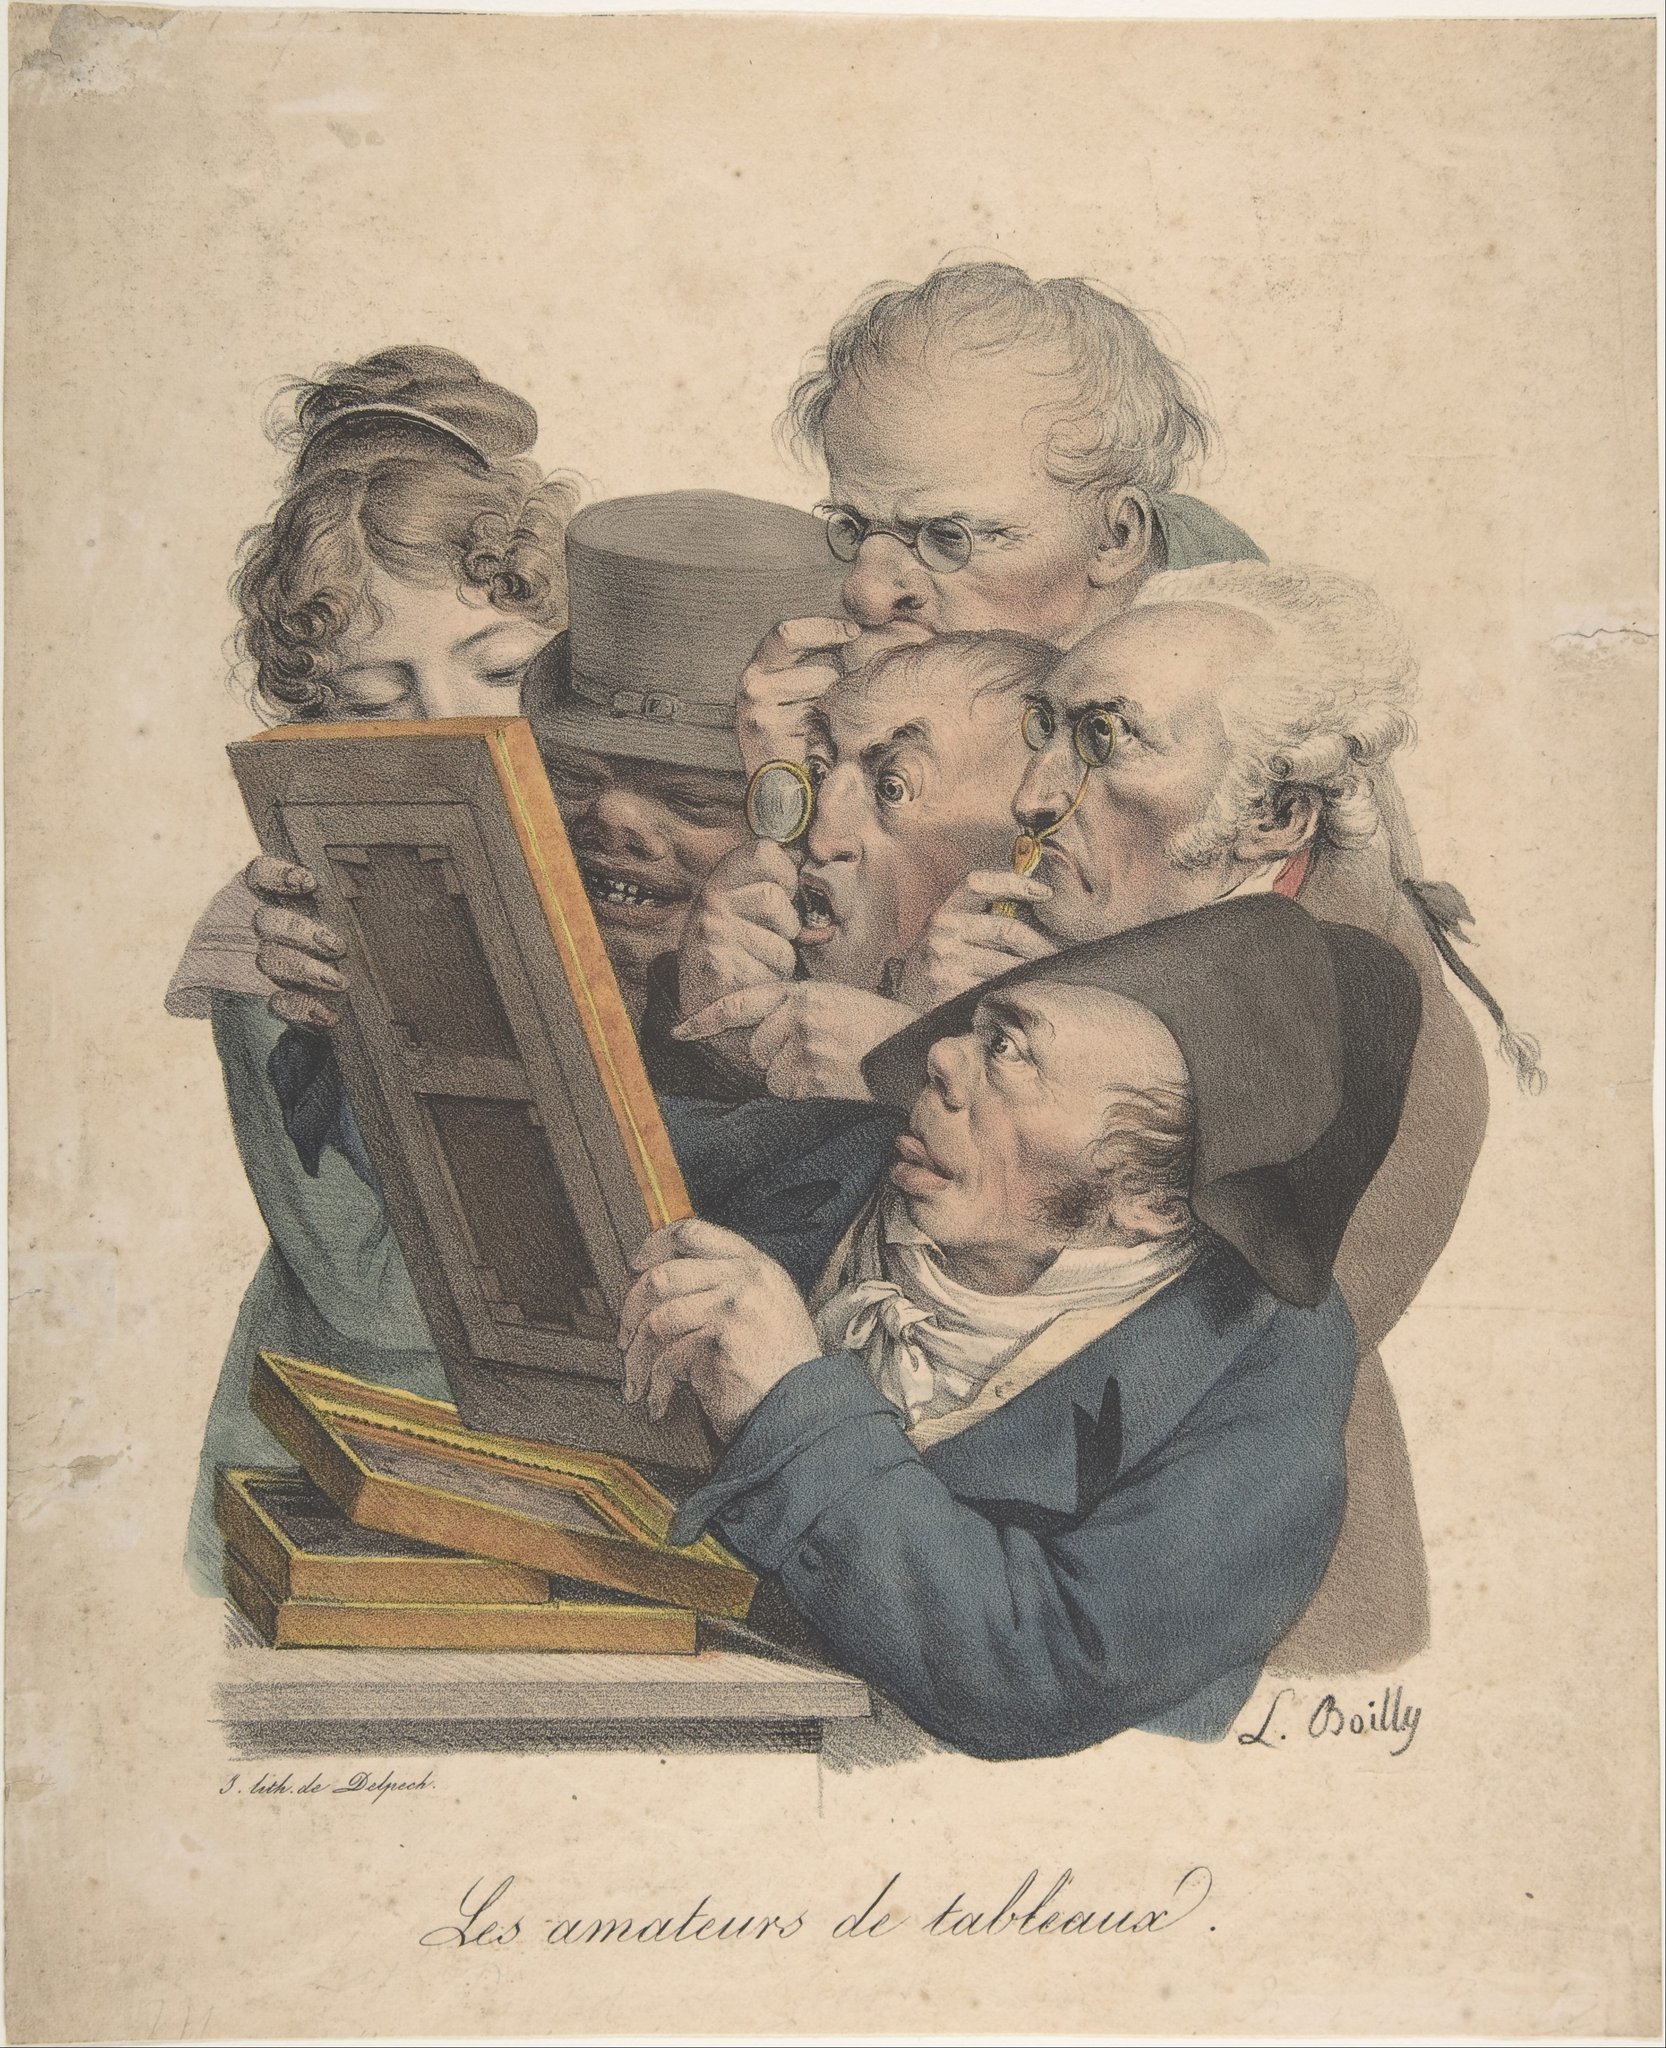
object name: print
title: The Art Connoisseurs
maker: louis léopold boilly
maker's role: artist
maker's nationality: french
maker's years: 1761-1845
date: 1823-1828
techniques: hand coloring, lithograph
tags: satire,men,women